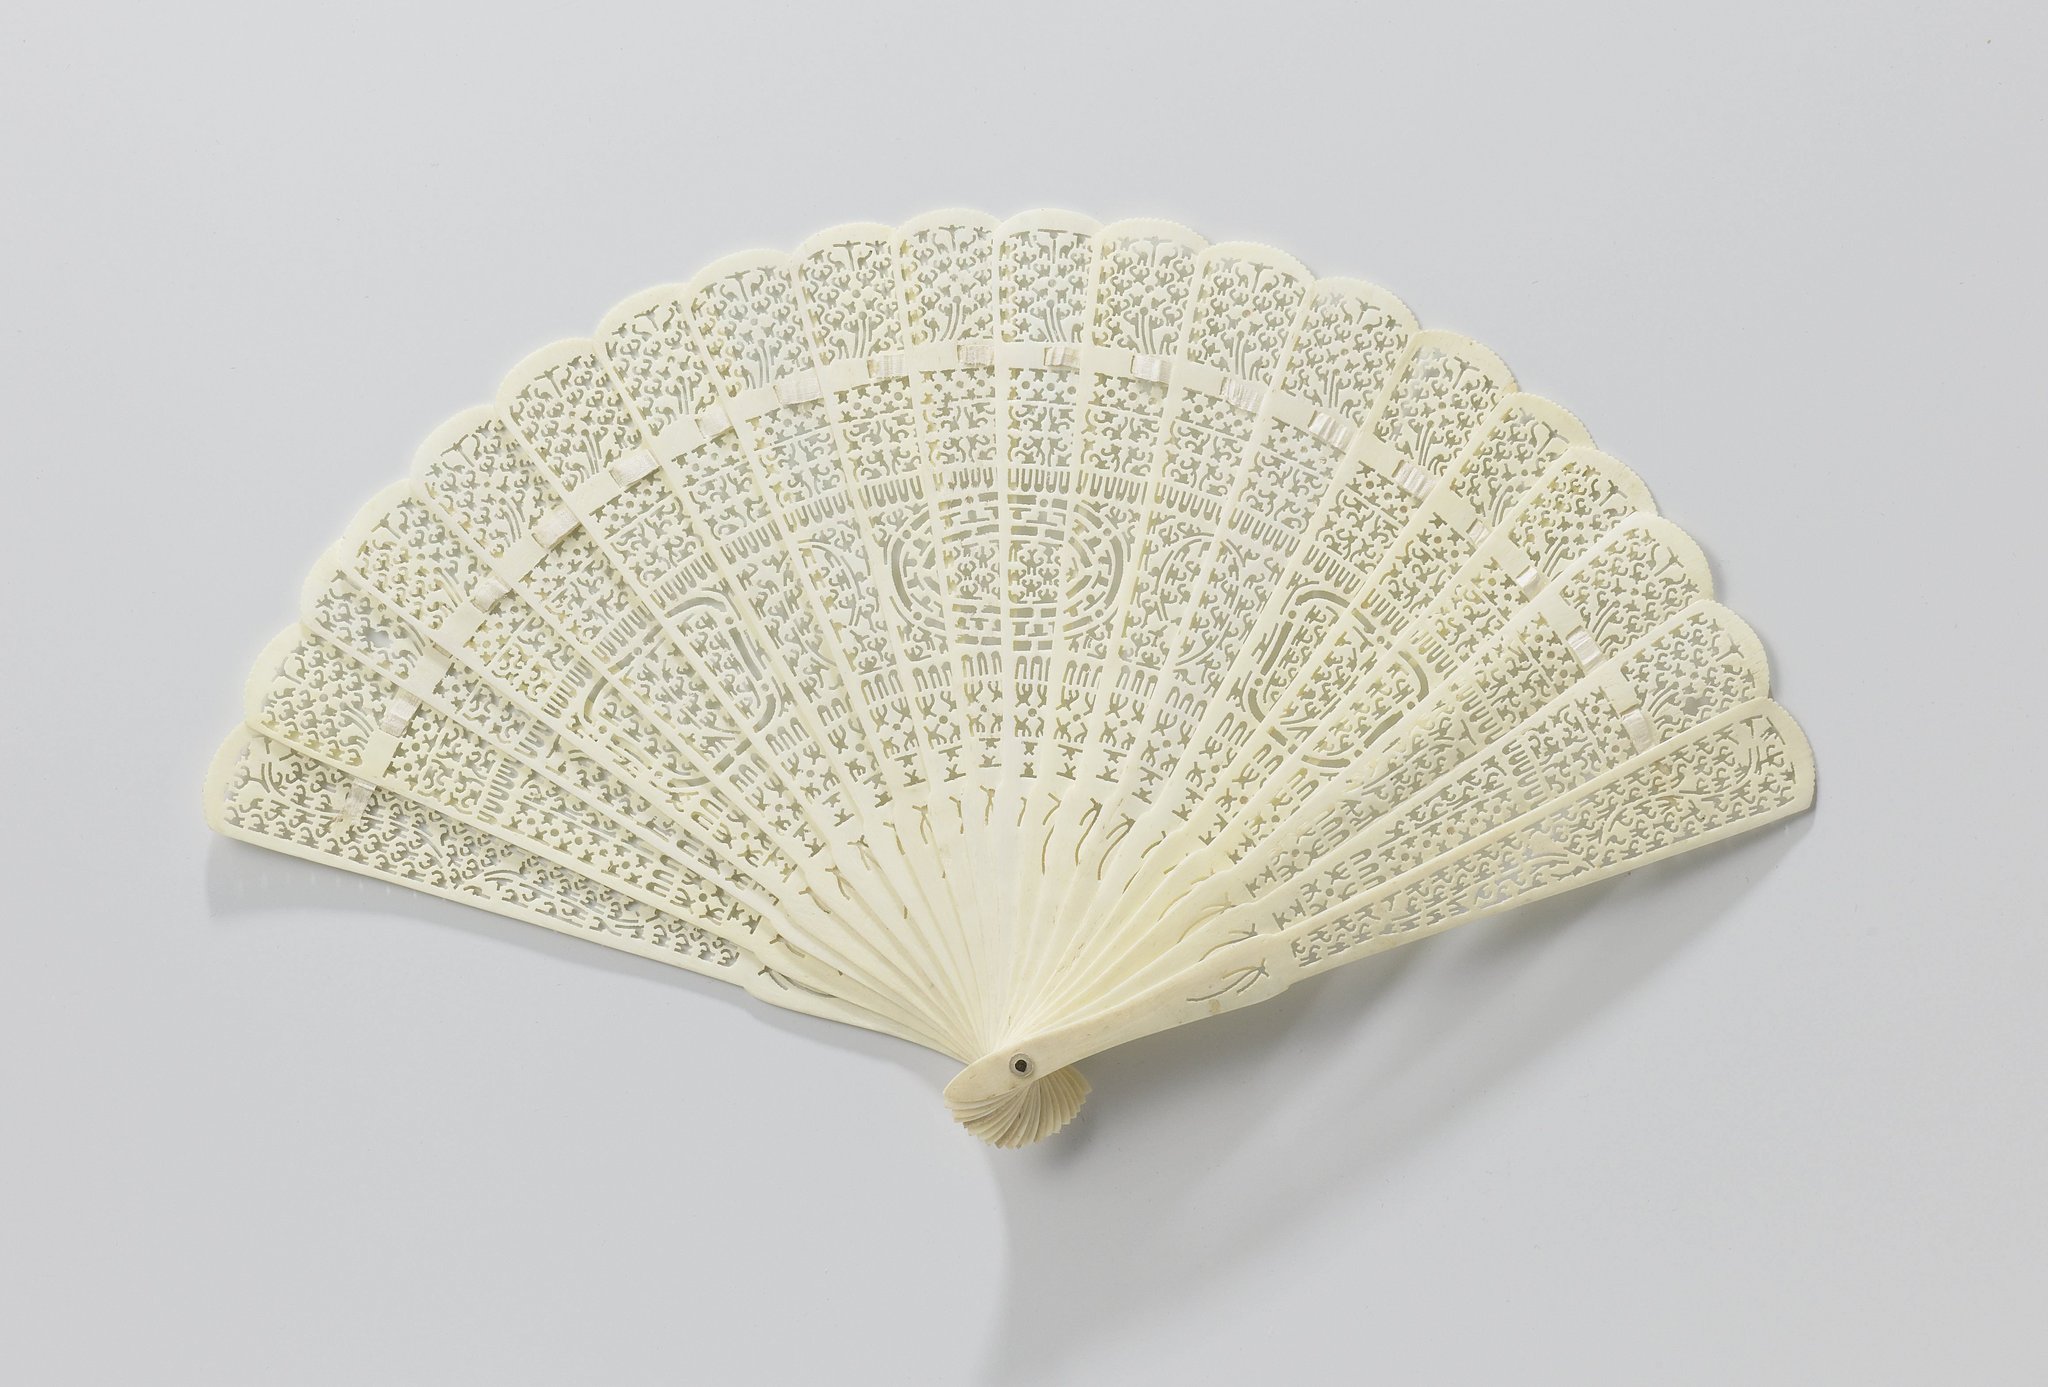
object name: brisé fan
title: Brisé-waaier van wit been à-jour gesneden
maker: Anonymous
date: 1800-1899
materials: bone, metal, mother of pearl, silk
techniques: cutting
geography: china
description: Brisé-waaier van wit been à-jour gesneden. De 20 aaneengesloten benen zijn voor 1/3 glad, voor 2/3 geheel van openwerk voorzien met drie geometrische vormen. Door de aaneenschakeling van openingen zijn drie medaillons binnen cirkelbogen ontstaan.